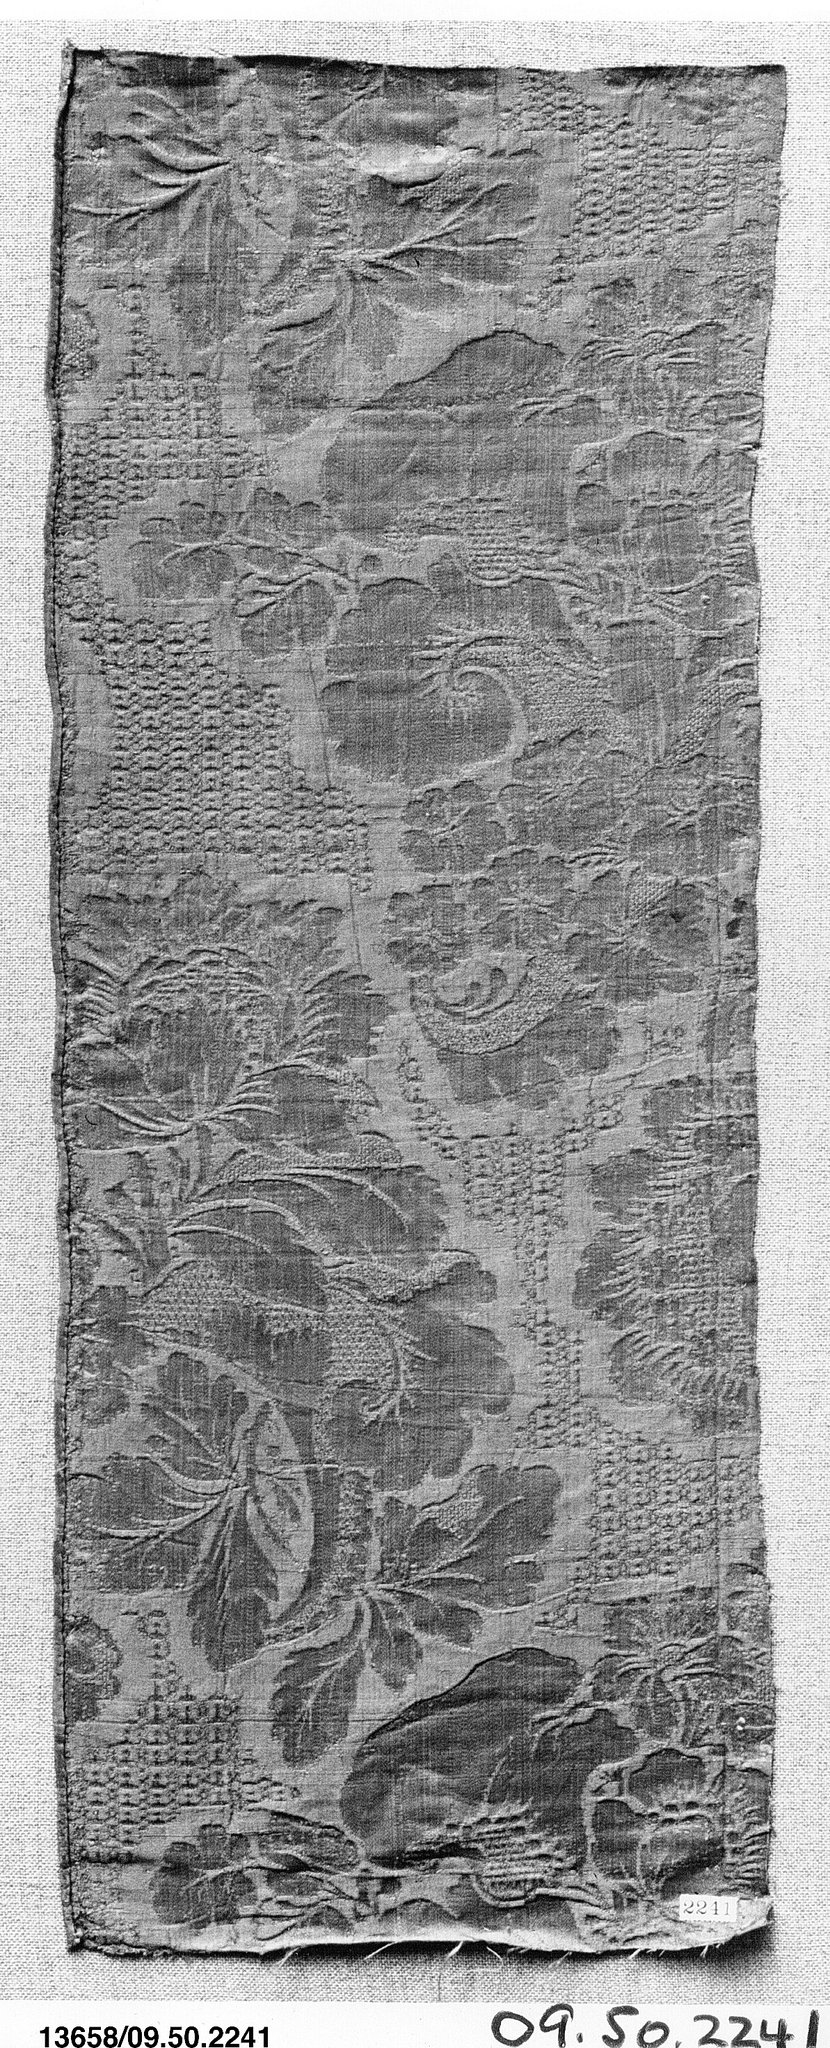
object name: piece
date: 1730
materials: silk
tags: leaves